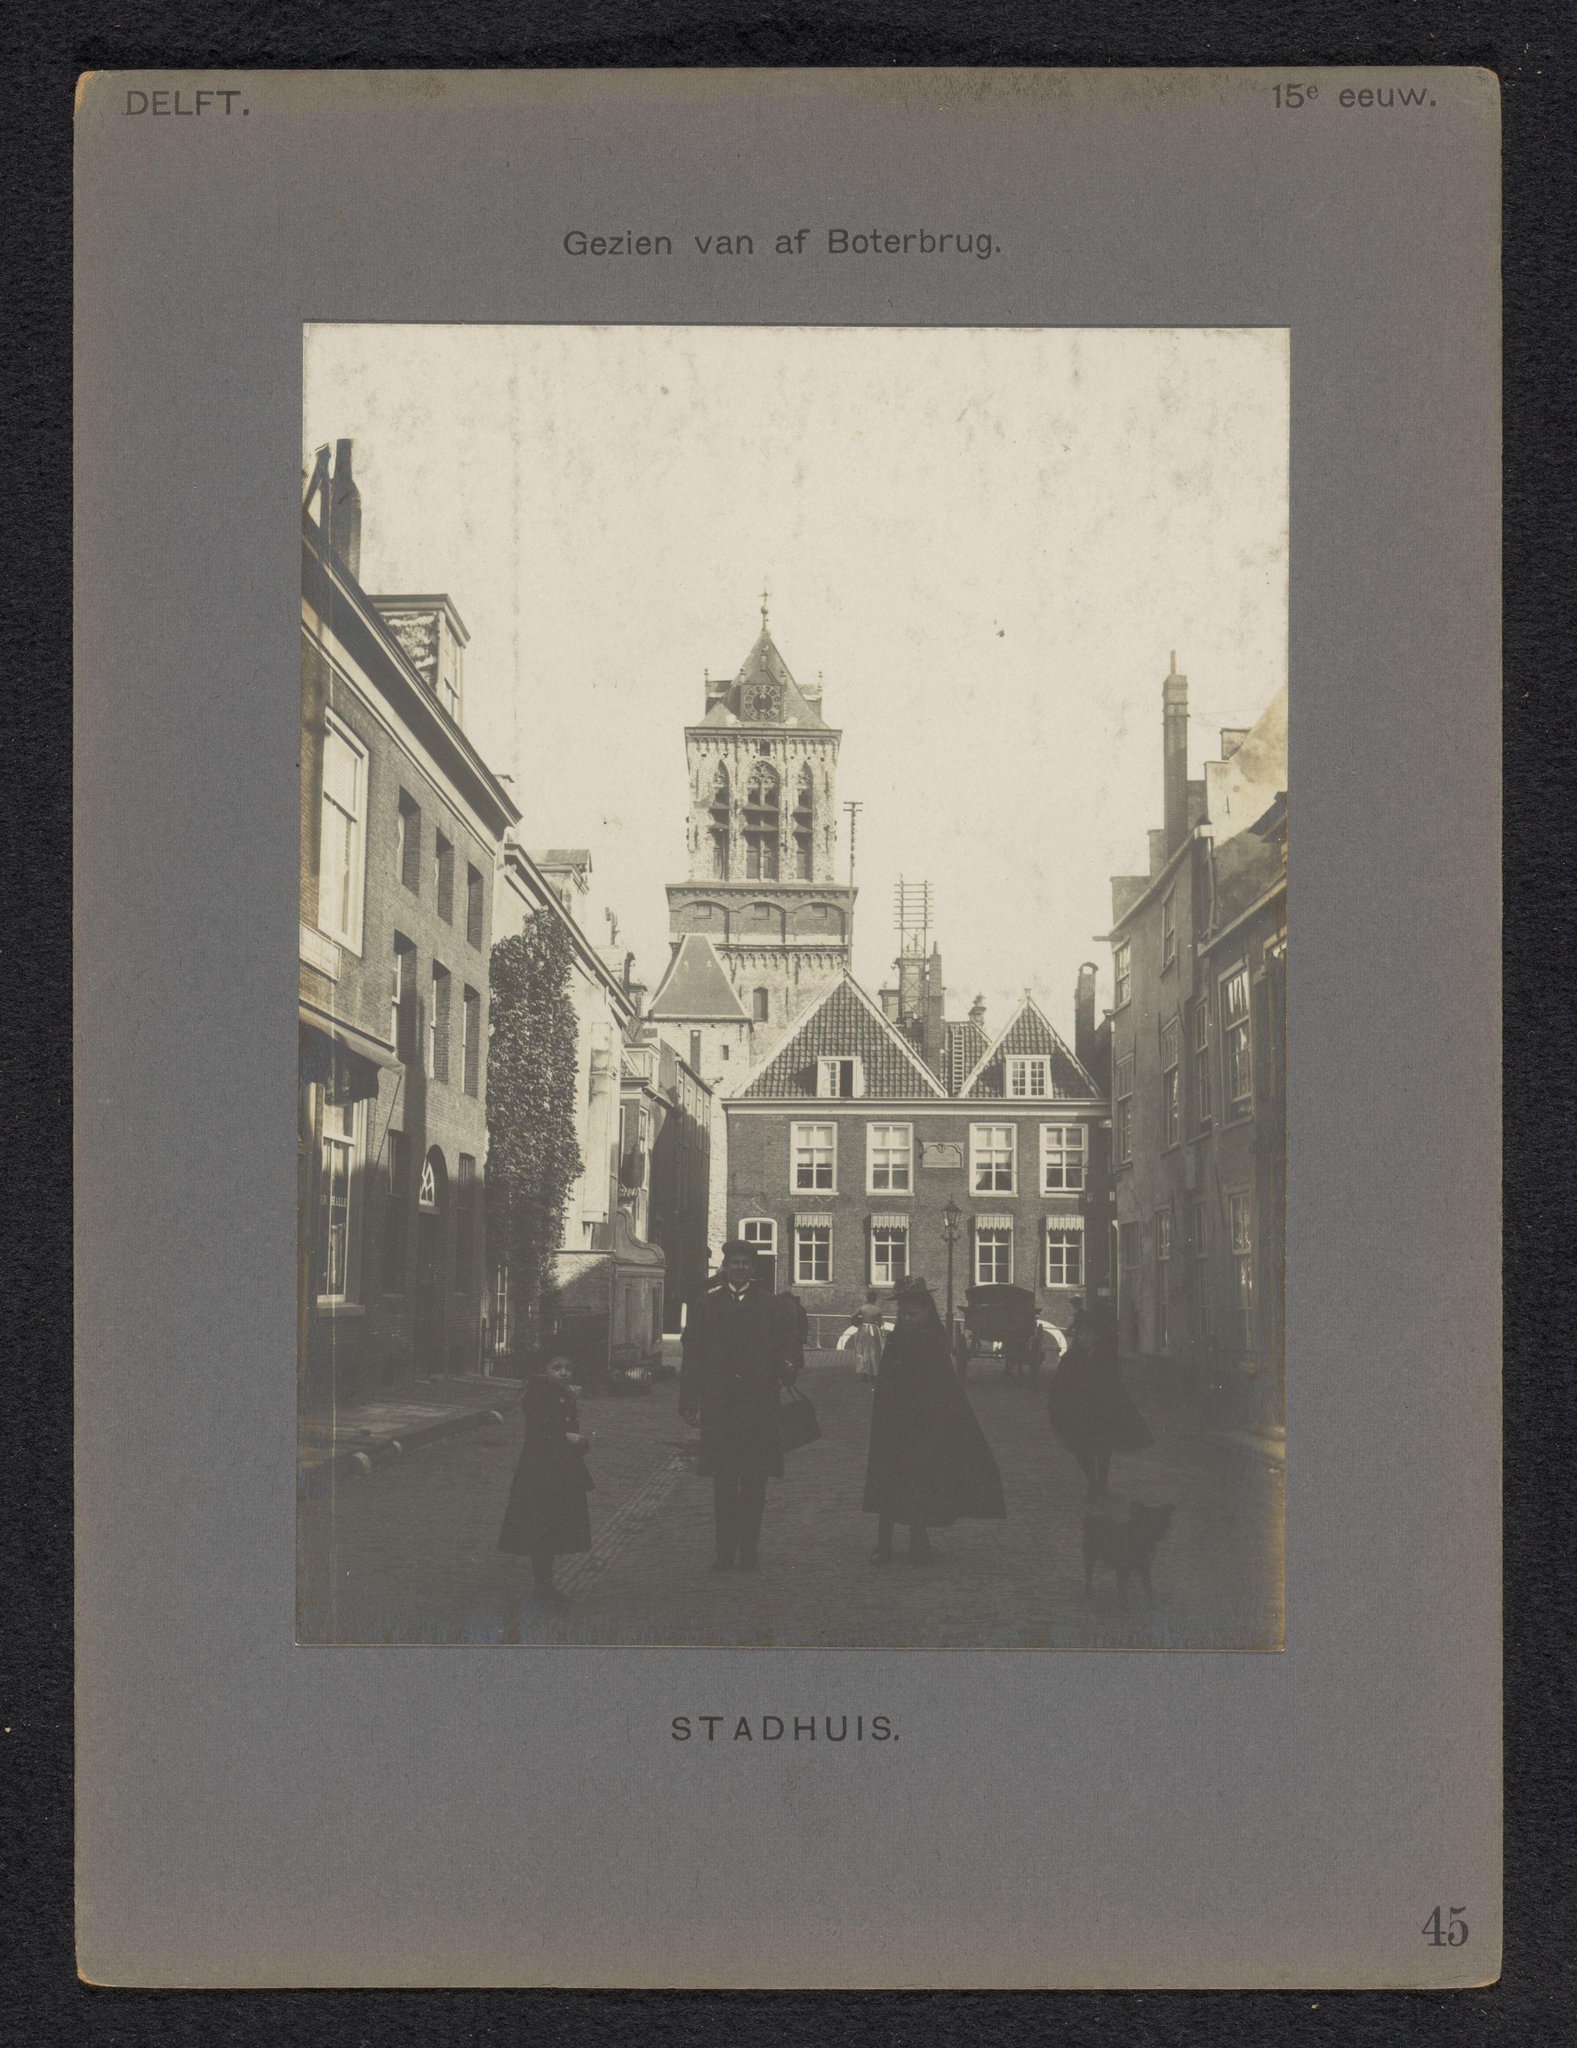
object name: photograph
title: Gezicht op het stadhuis in Delft, gezien vanaf de Boterbrug met mensen, een koets en een hond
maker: Anonymous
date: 1900-1904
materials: cardboard, photographic support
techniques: gelatin silver print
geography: delft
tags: bus, coach, townhall, dog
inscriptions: number: ‘45’, inscription: ‘Het recht van reproductie dezer photo's wordt door den Uitgever voorbehouden.’, inscription: ‘Delft. 15e eeuw.’